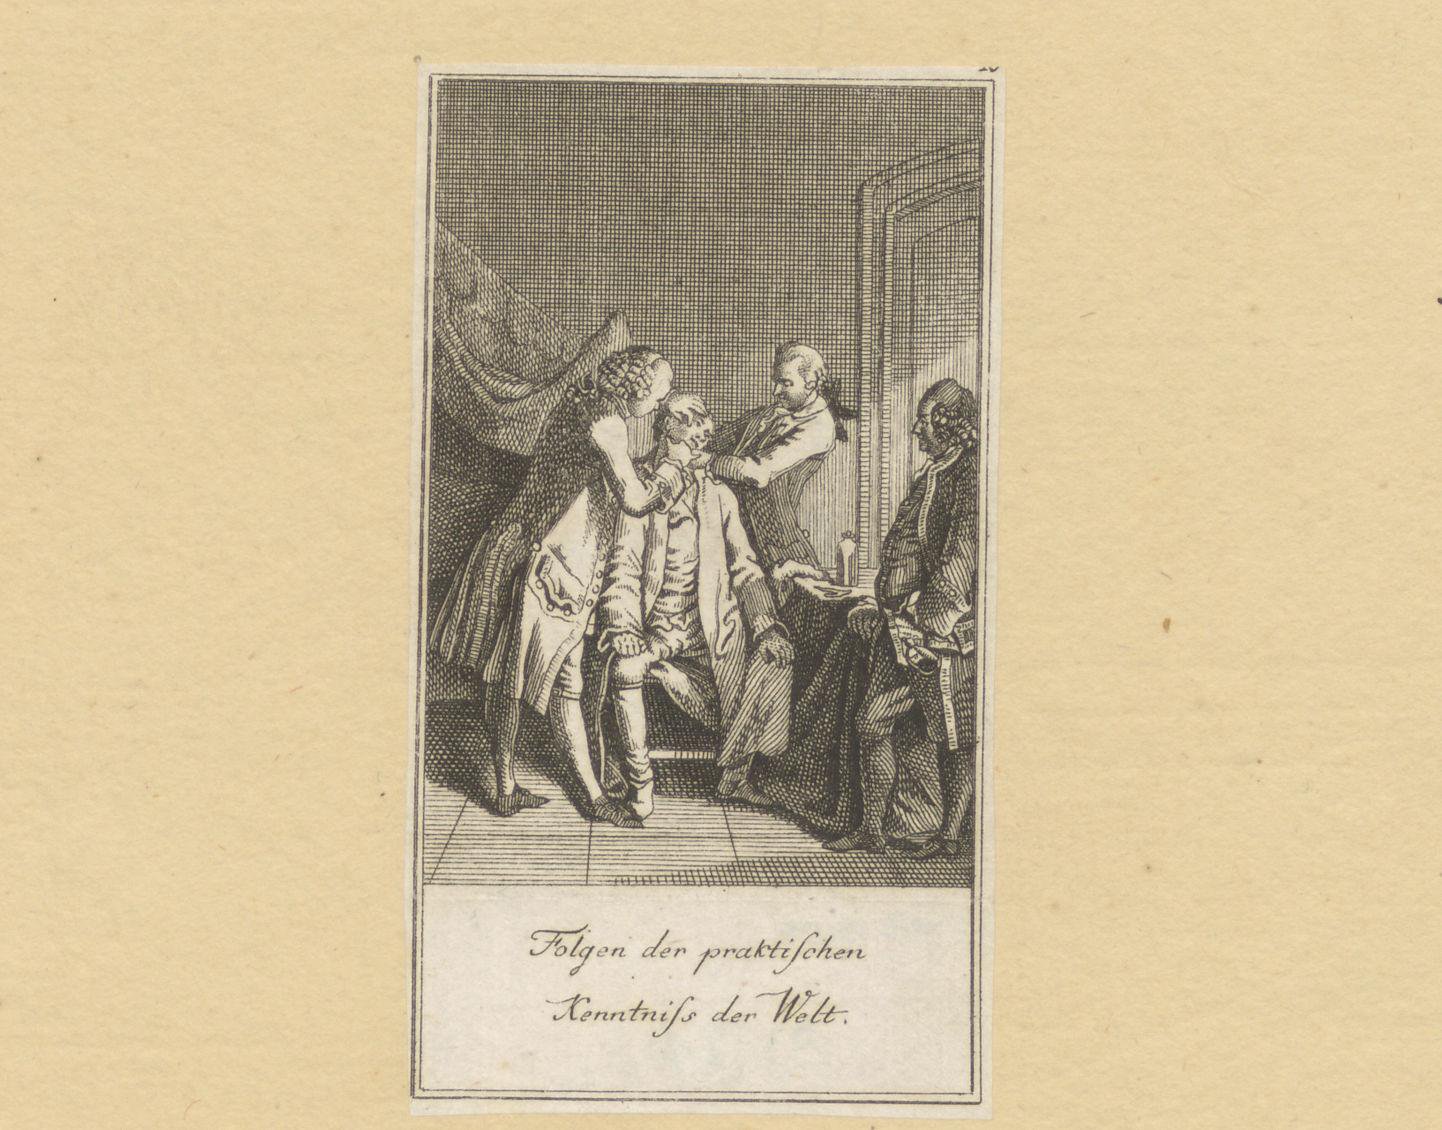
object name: print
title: Arts onderzoekt een patiënt die aan syfilis lijdt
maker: daniel berger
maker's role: print maker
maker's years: 1744-1824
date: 1773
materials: paper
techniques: etching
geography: berlin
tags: physician, doctor, medical examination, medical treatment, skin and venereal diseases: syphilis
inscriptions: collector's mark: Lugt 2228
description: Prent afkomstig uit: Genealogischer Calender auf das Jahr 1774. Mit Genehmigung der Königlichen Academie der Wissenschaften zu Berlin herausgegeben. Tiende scène uit de serie 'Das Leben eines Lüderlichen', bestaand uit twaalf scènes, gedrukt van een koperplaat.